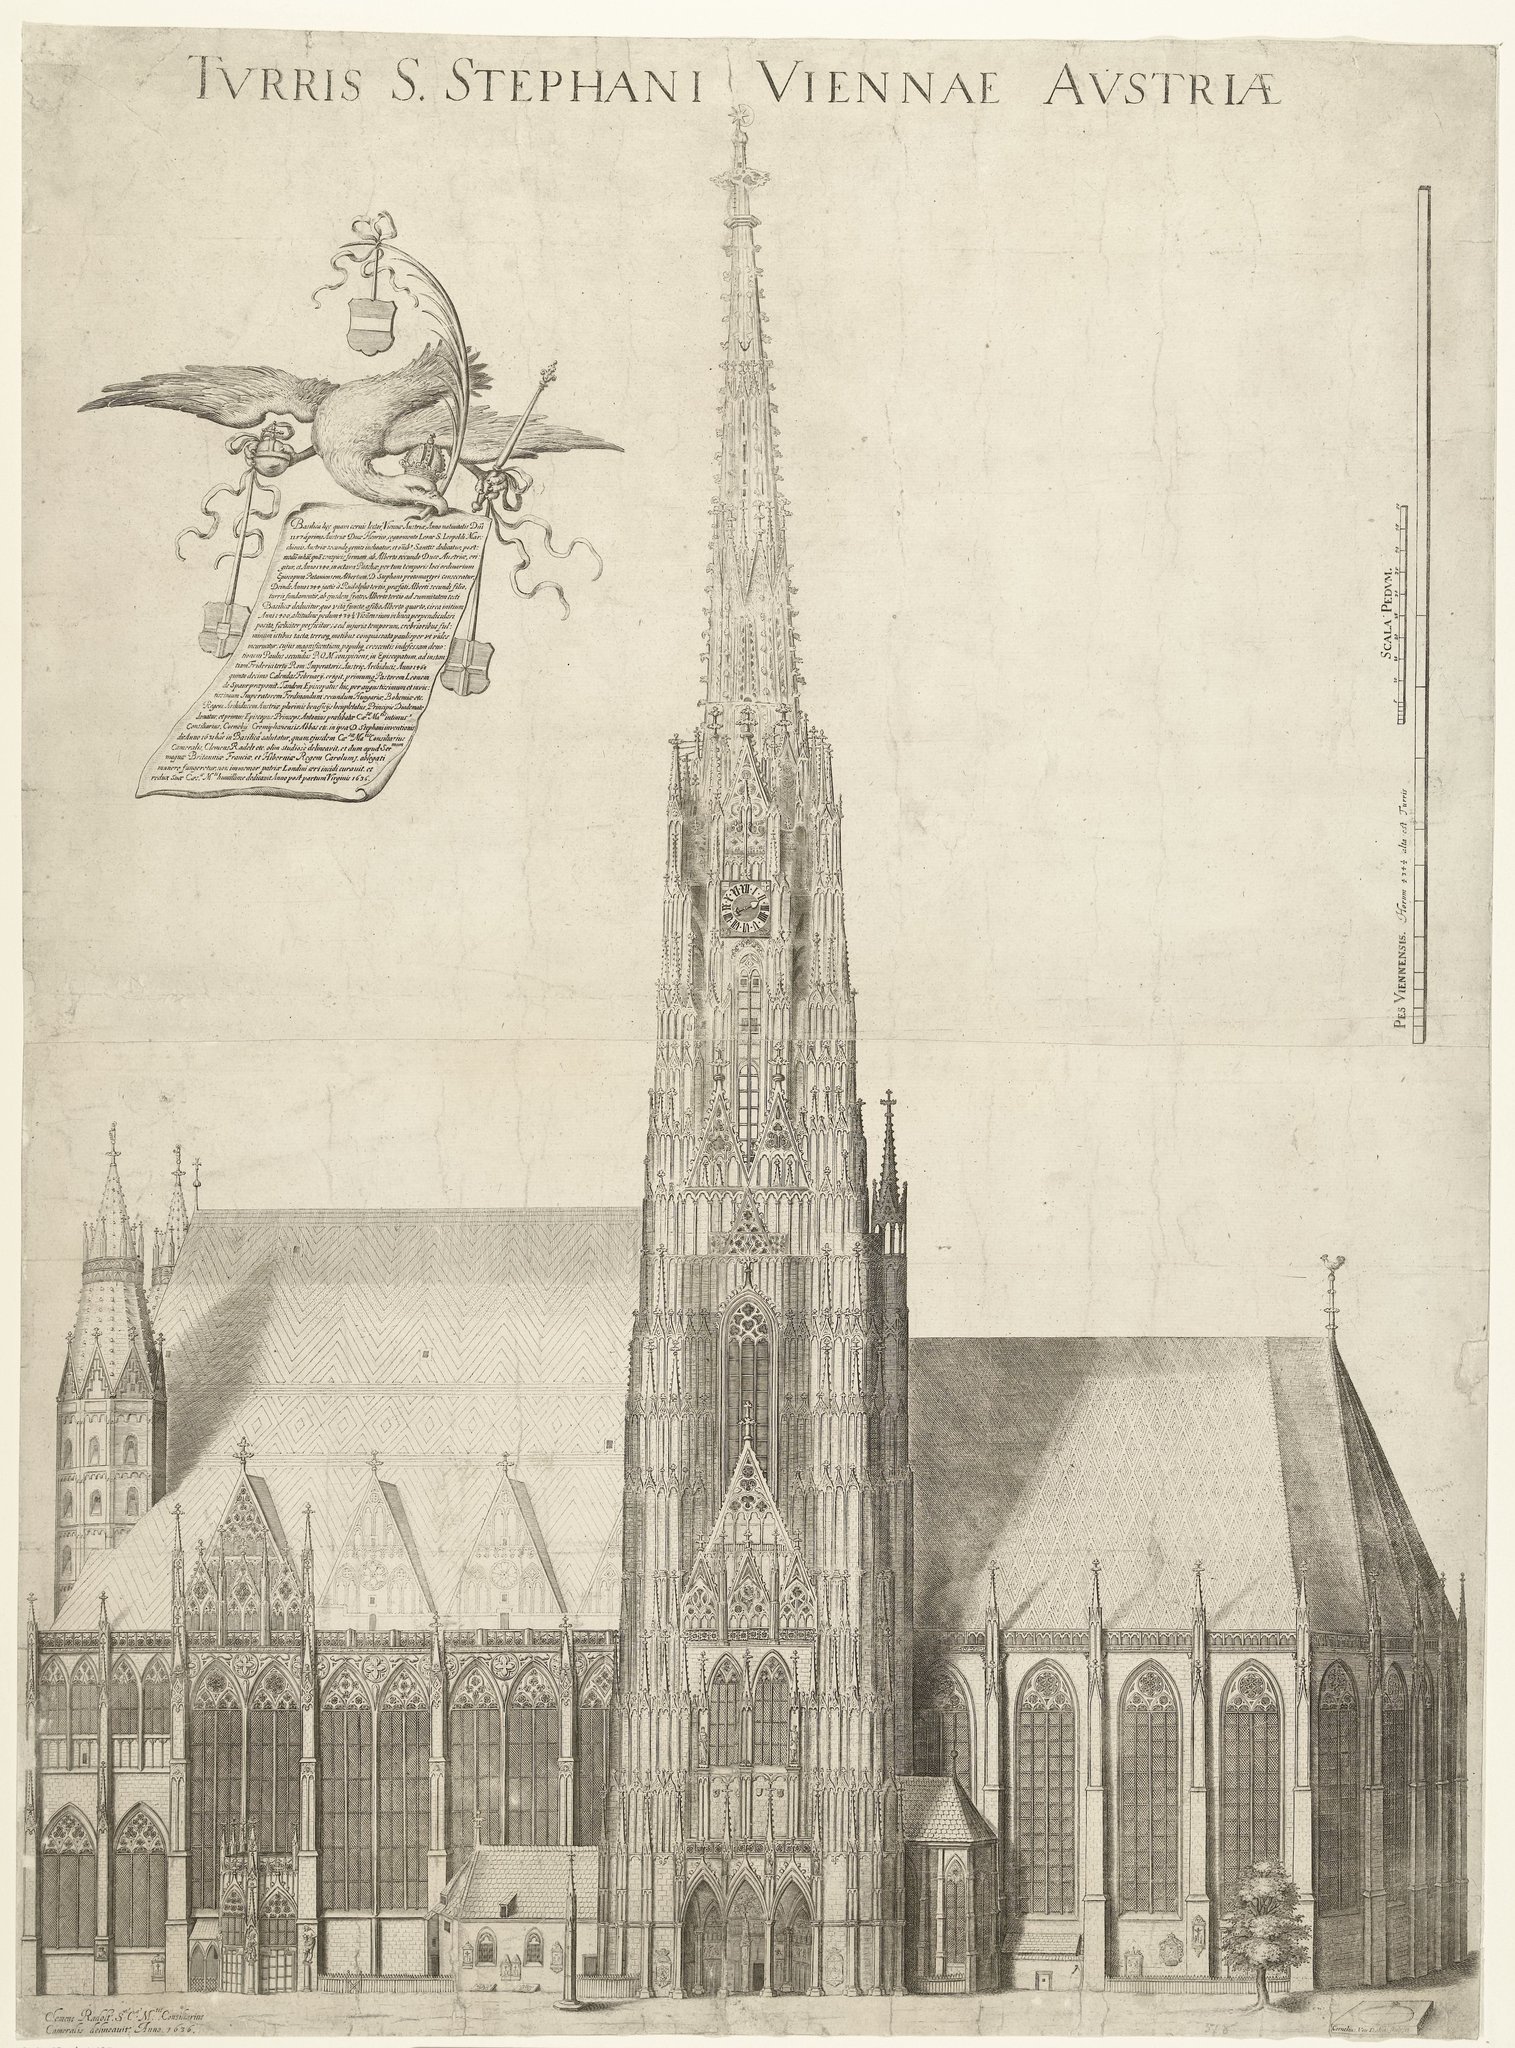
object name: print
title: Exterieur van Sankt Stephansdom te Wenen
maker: cornelis van dalen (i)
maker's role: print maker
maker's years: 1602-1665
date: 1636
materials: paper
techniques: engraving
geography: london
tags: church (exterior), vienna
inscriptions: collector's mark: Lugt 2228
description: Exterieur van Sankt Stephansdom te Wenen. Heraldische adelaar draagt scepter, kroon en rijksappel en in zijn snavel een blad met Latijnse tekst over de afgebeelde kerk. Langs de rand een schaalverdeling.